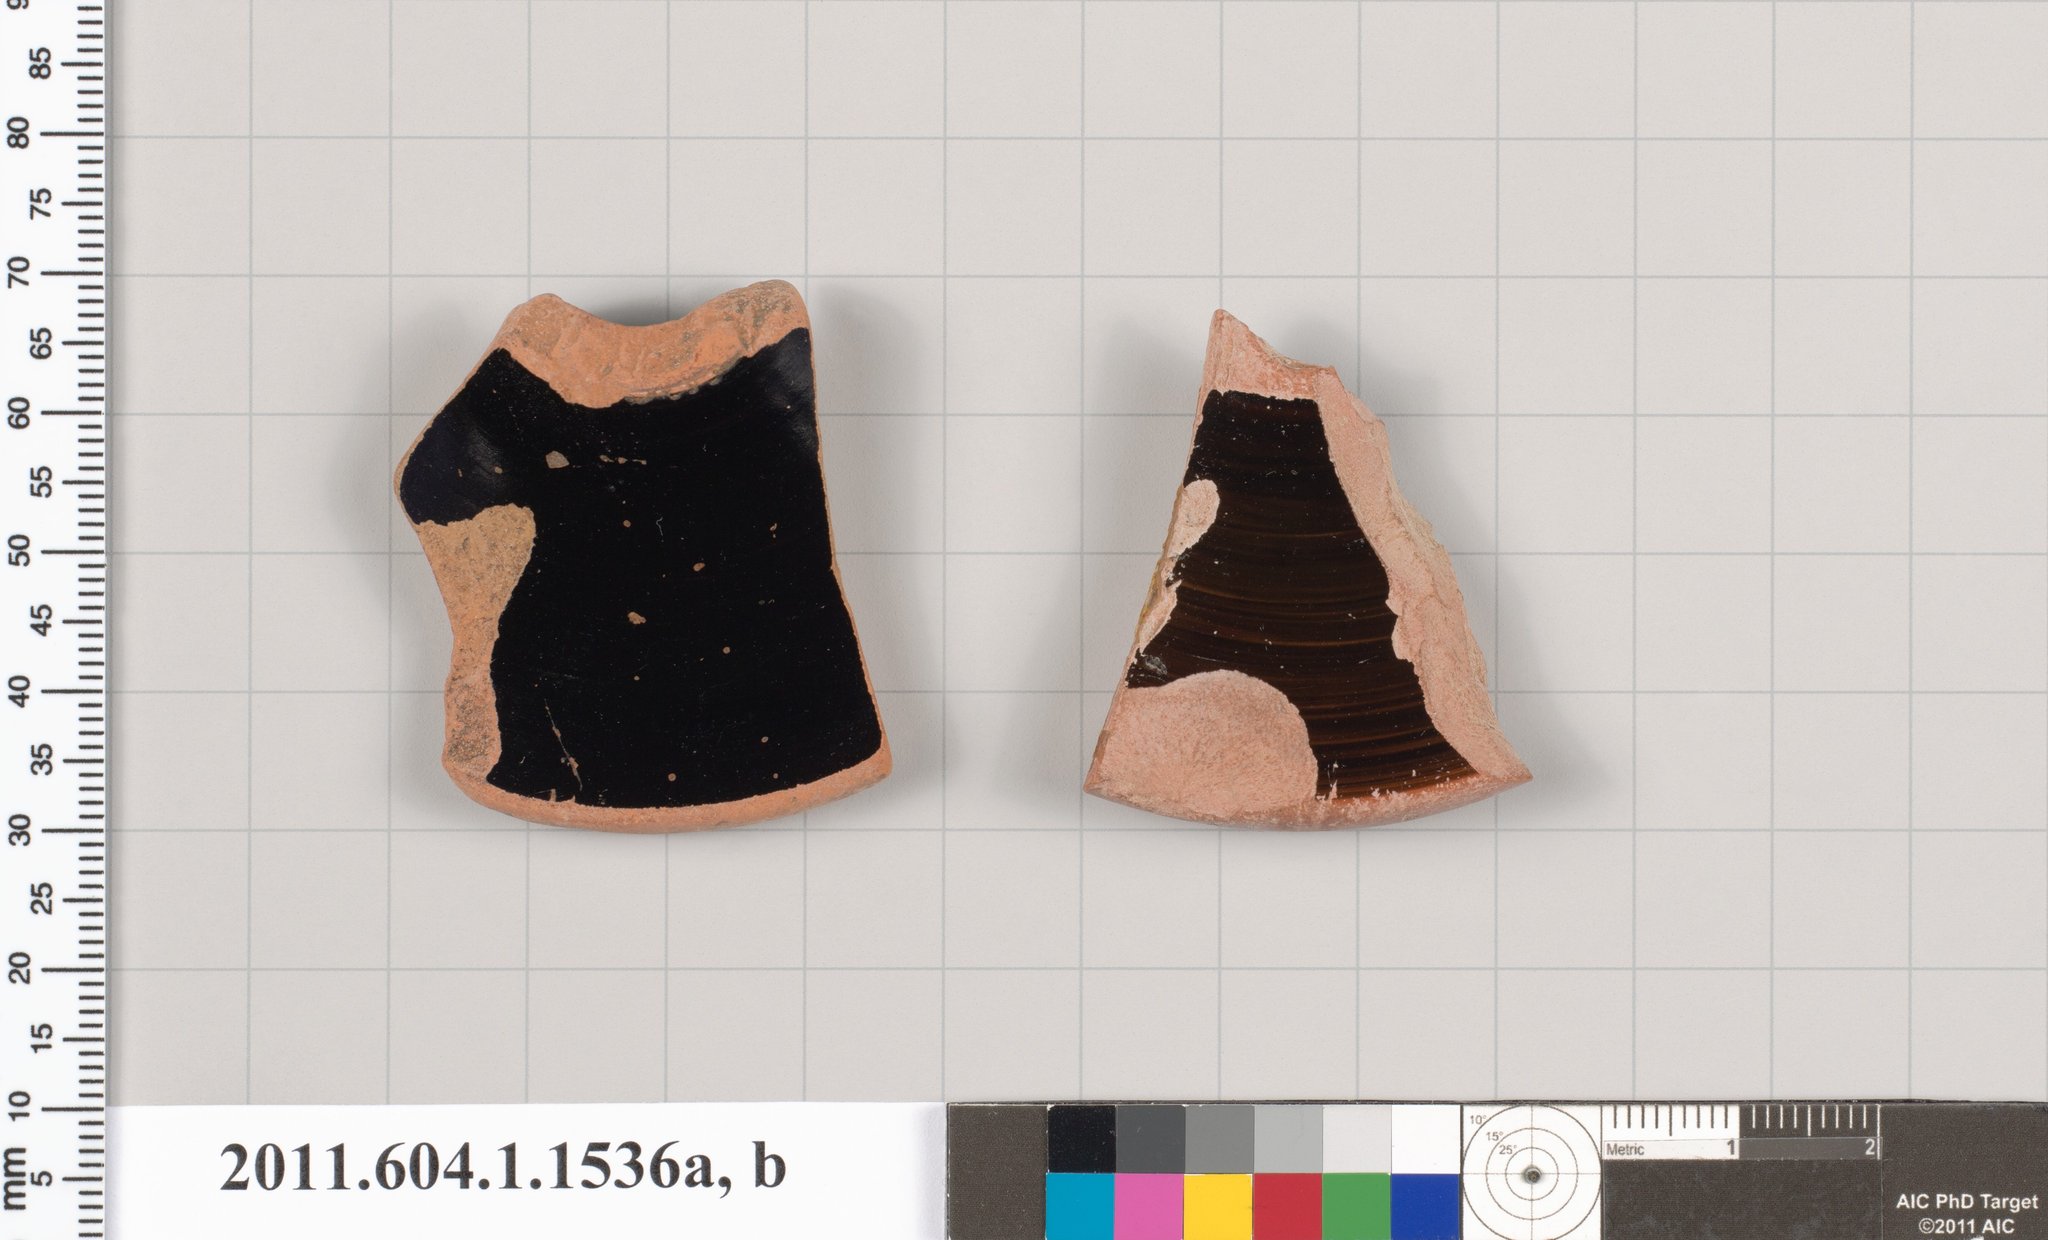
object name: kylix fragment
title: Terracotta fragments of kylikes (drinking cups)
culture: greek, attic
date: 500-401 BCE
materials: terracotta